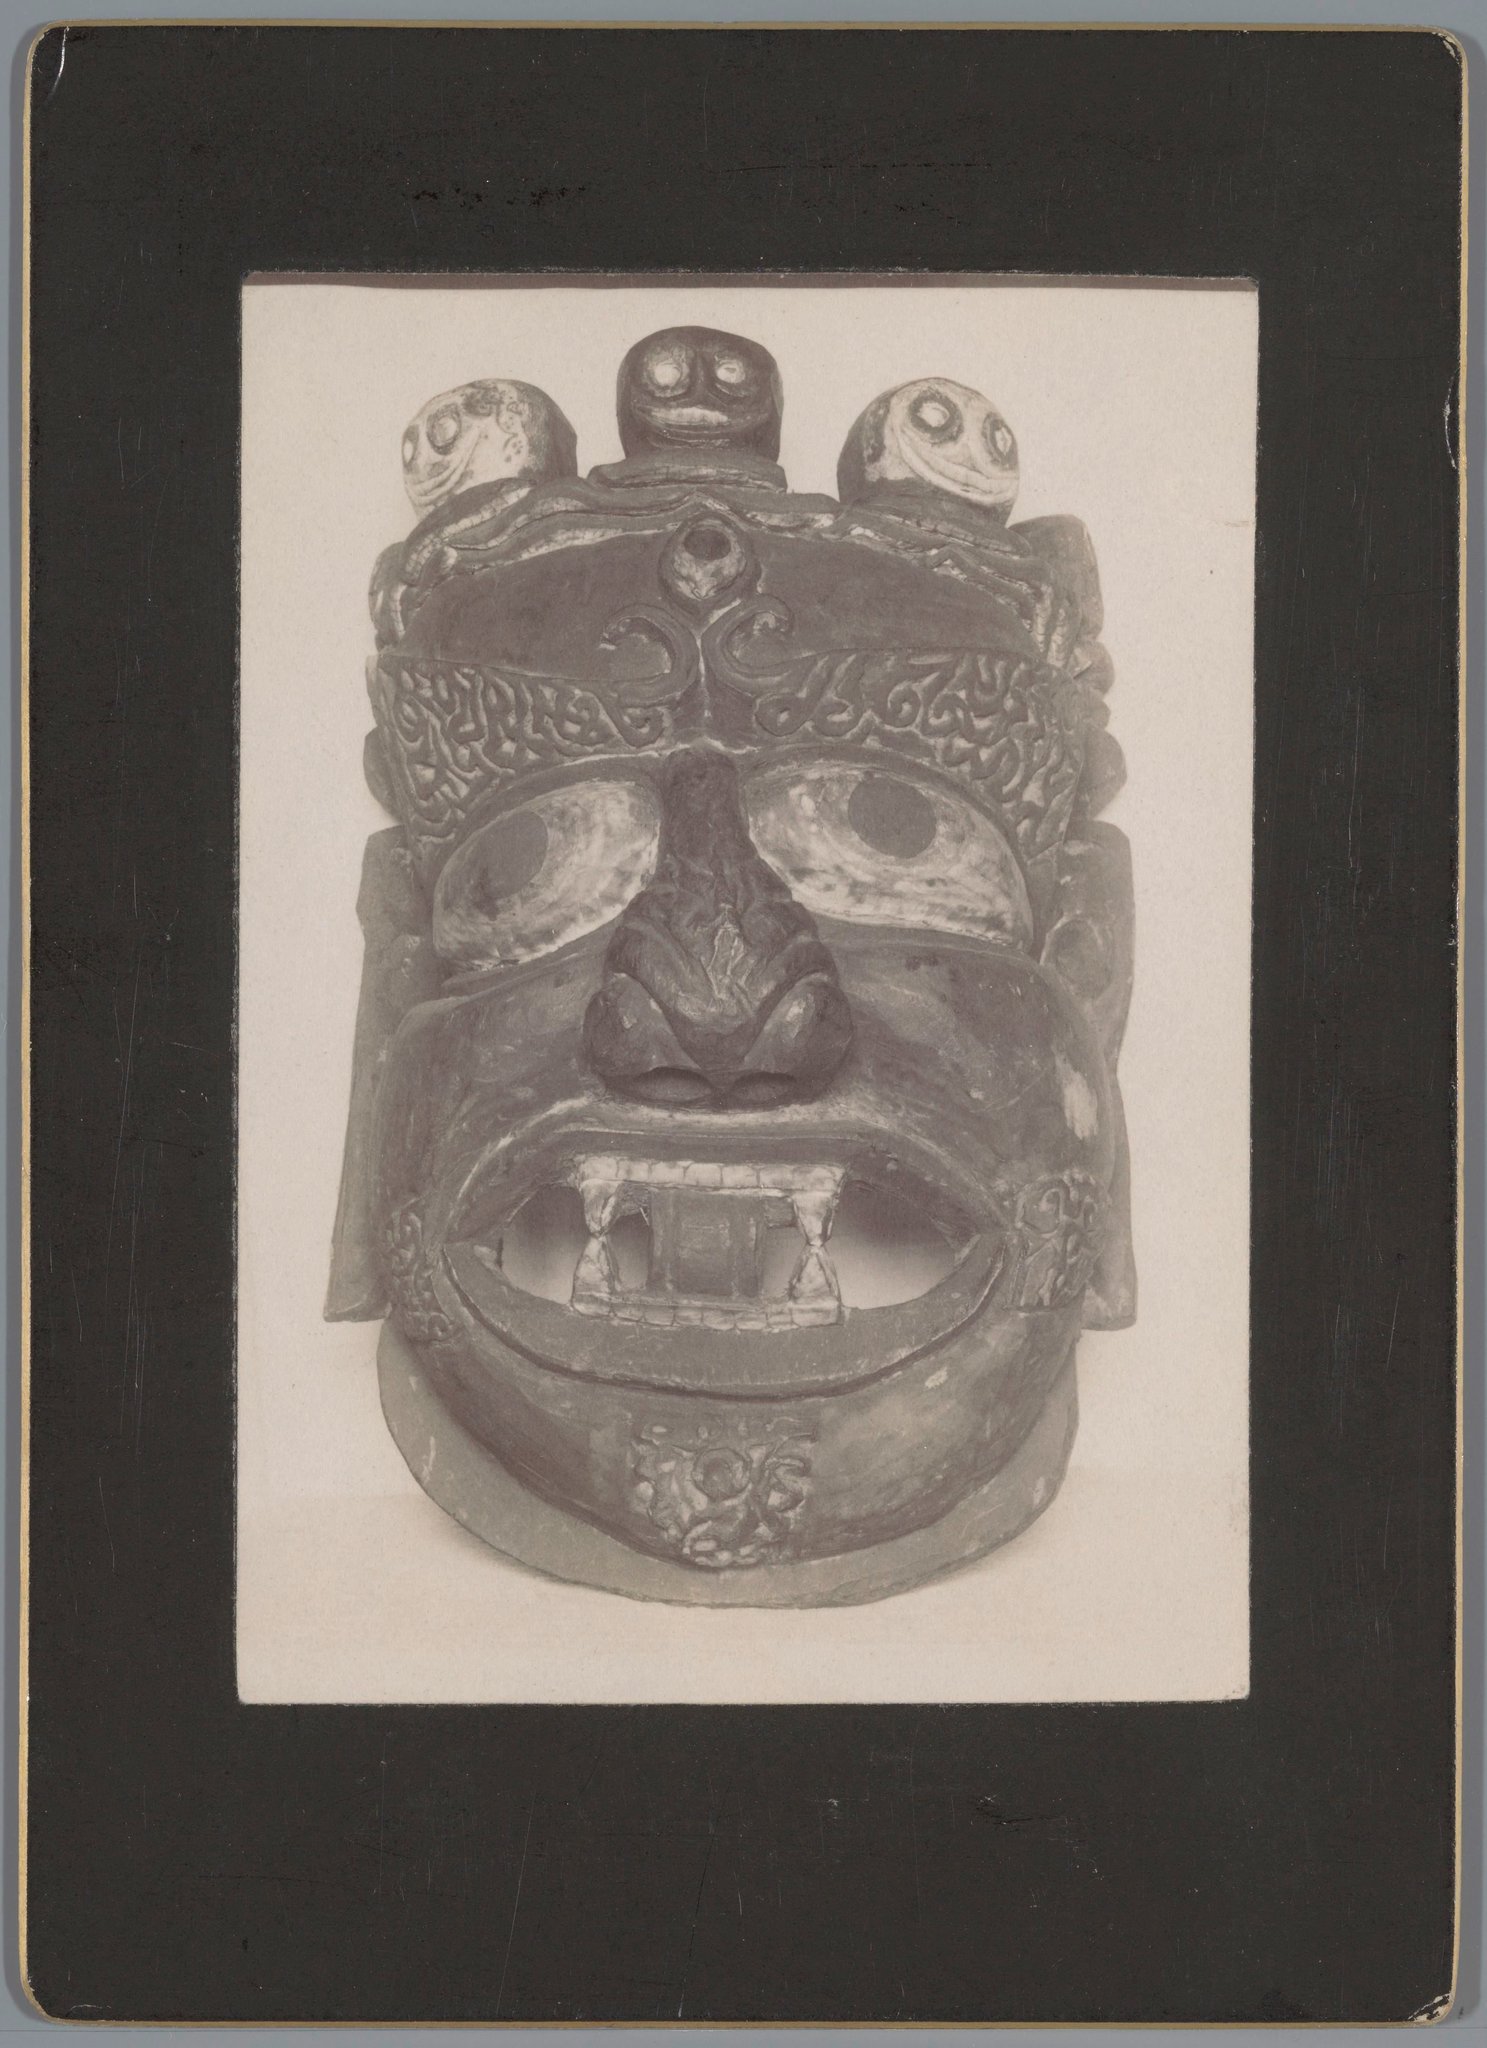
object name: photograph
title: Houten masker van den Duivelskoning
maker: Anonymous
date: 1897-1910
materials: cardboard, paper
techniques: albumen print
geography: tibet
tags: mask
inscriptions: inscription: ‘Houten masker van den/ Duivelskoning/ door Lamaistische priesters/ gedragen/ Afmeting 3hx55 cM/ Thibet’